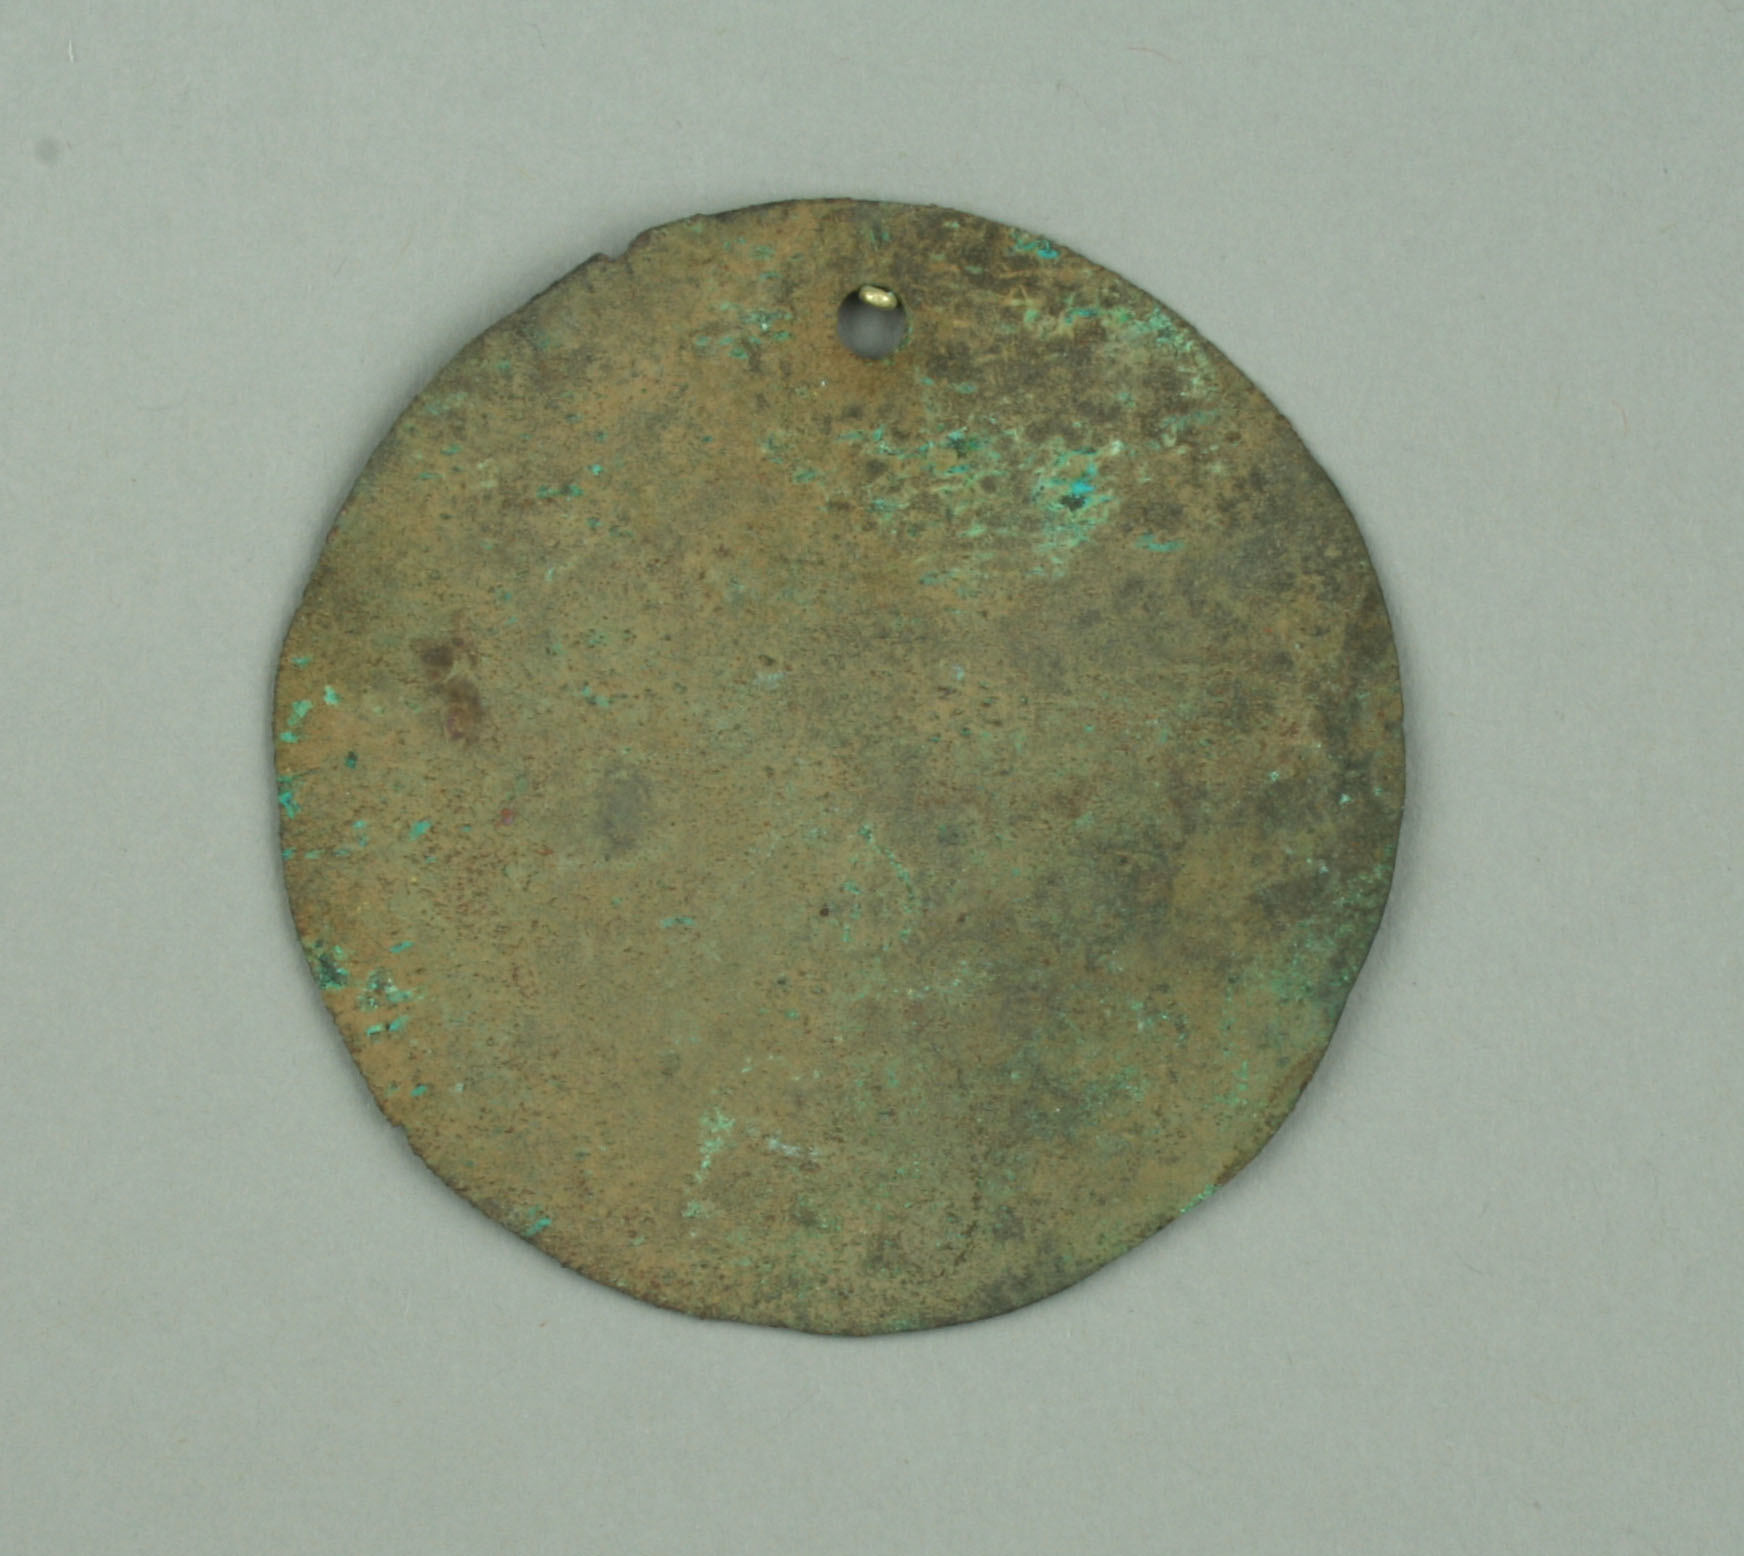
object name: plaque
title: Round Plaque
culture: vicús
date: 300 BCE-200 CE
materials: copper, gilt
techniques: hammering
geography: peru